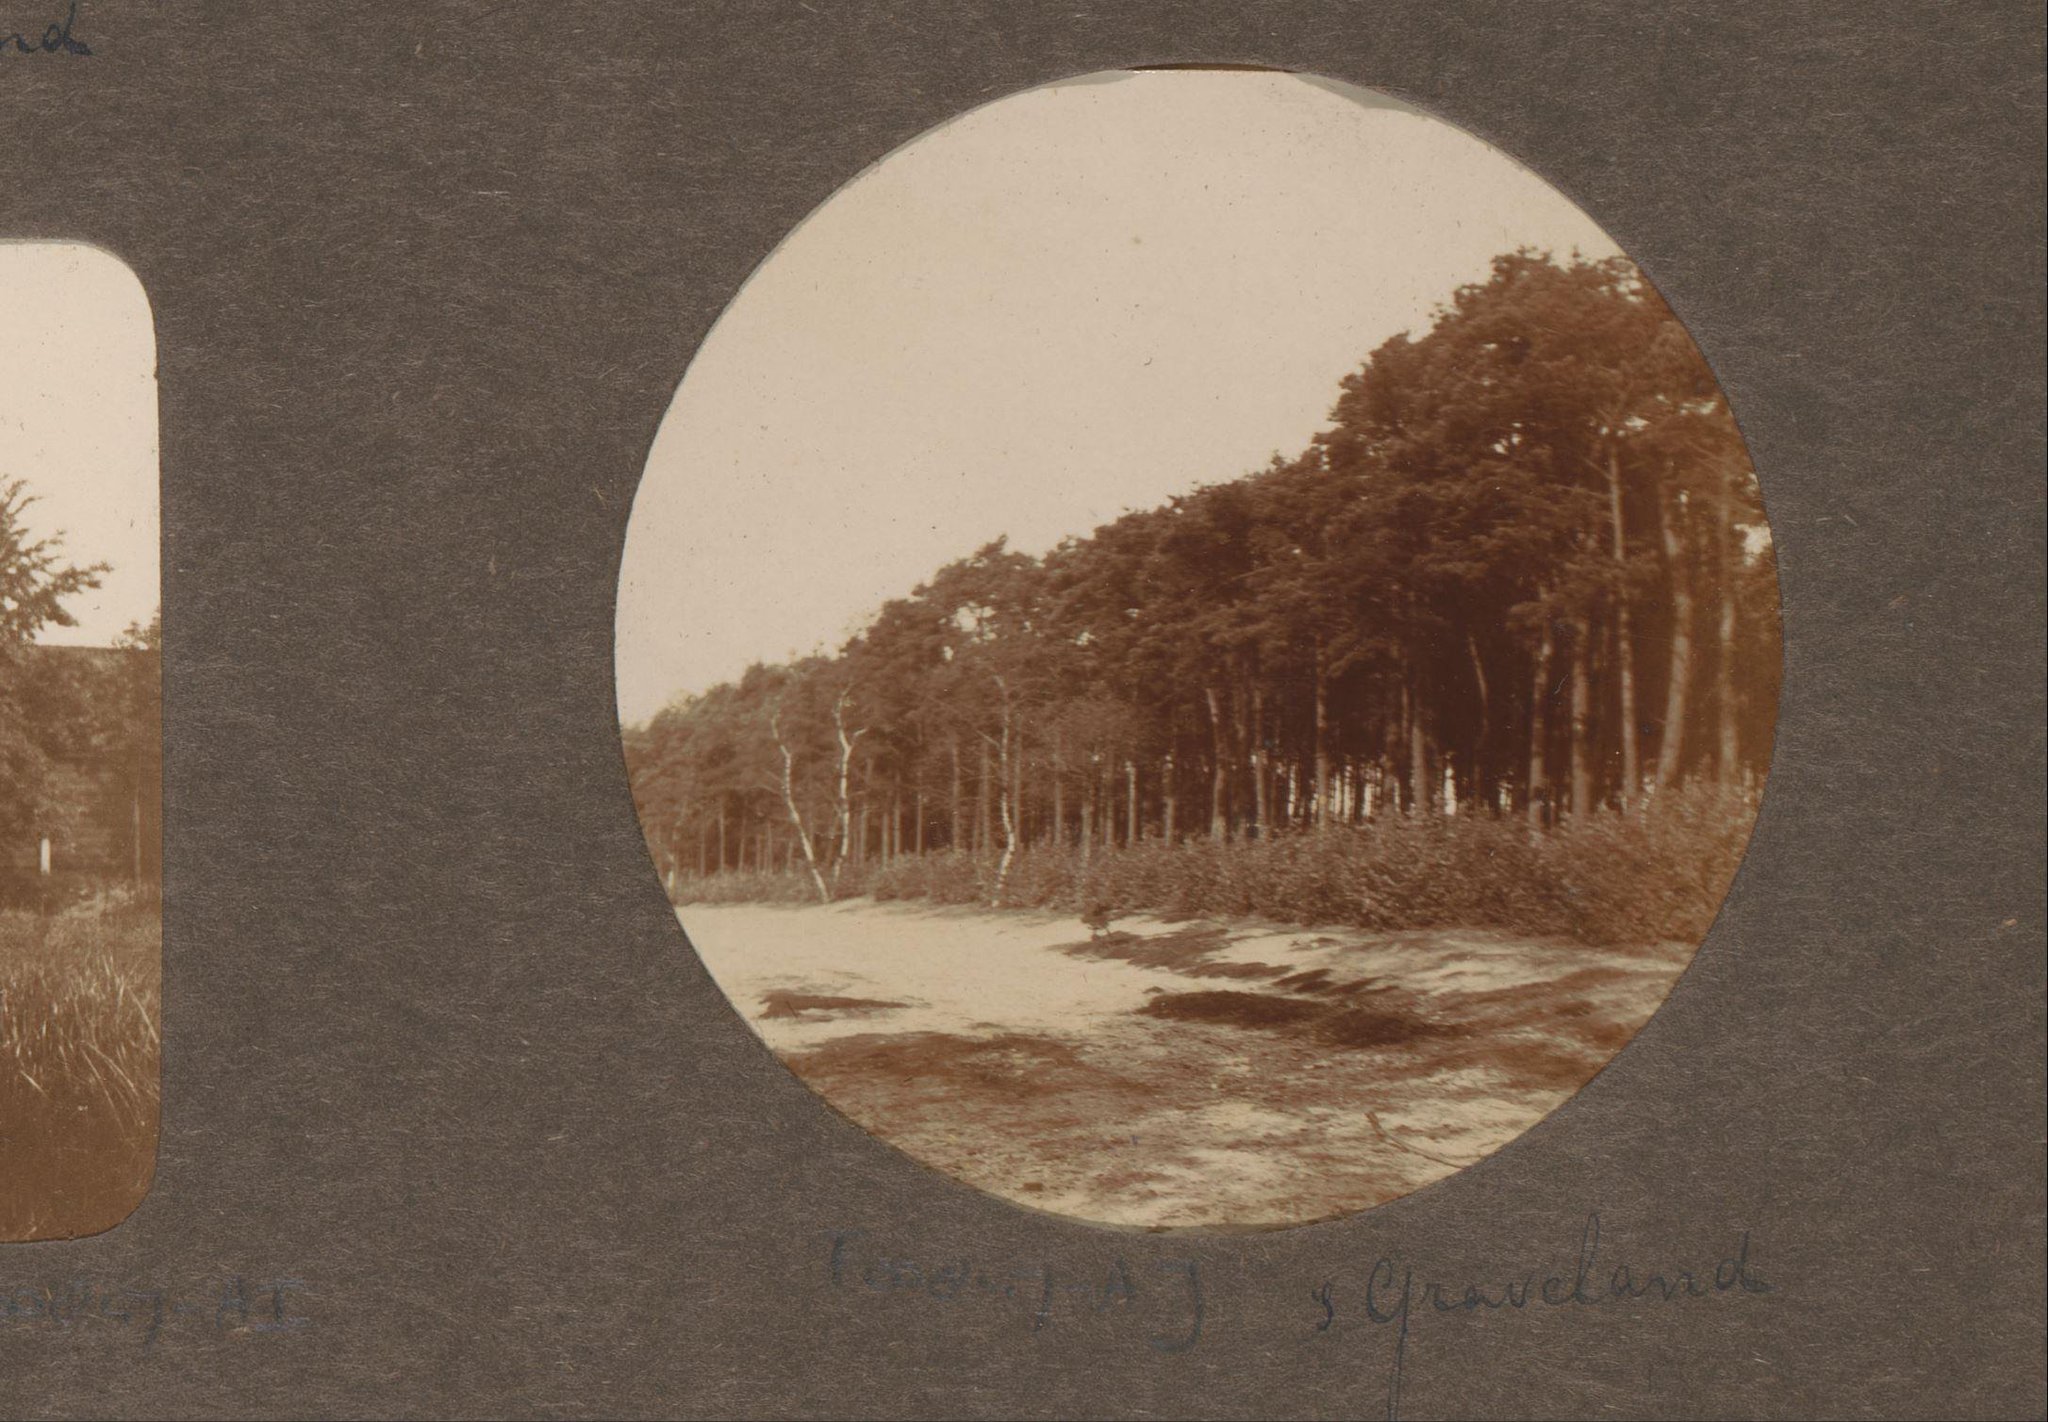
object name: album leaf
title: Bosrand in 's-Graveland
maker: Anonymous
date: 1902-1906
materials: cardboard, paper, photographic support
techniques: gelatin silver print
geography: s-graveland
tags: forest, wood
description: Onderdeel van Reisalbum van een Nederlandse familie met bezienswaardigheden in Europa, Egypte en New York.